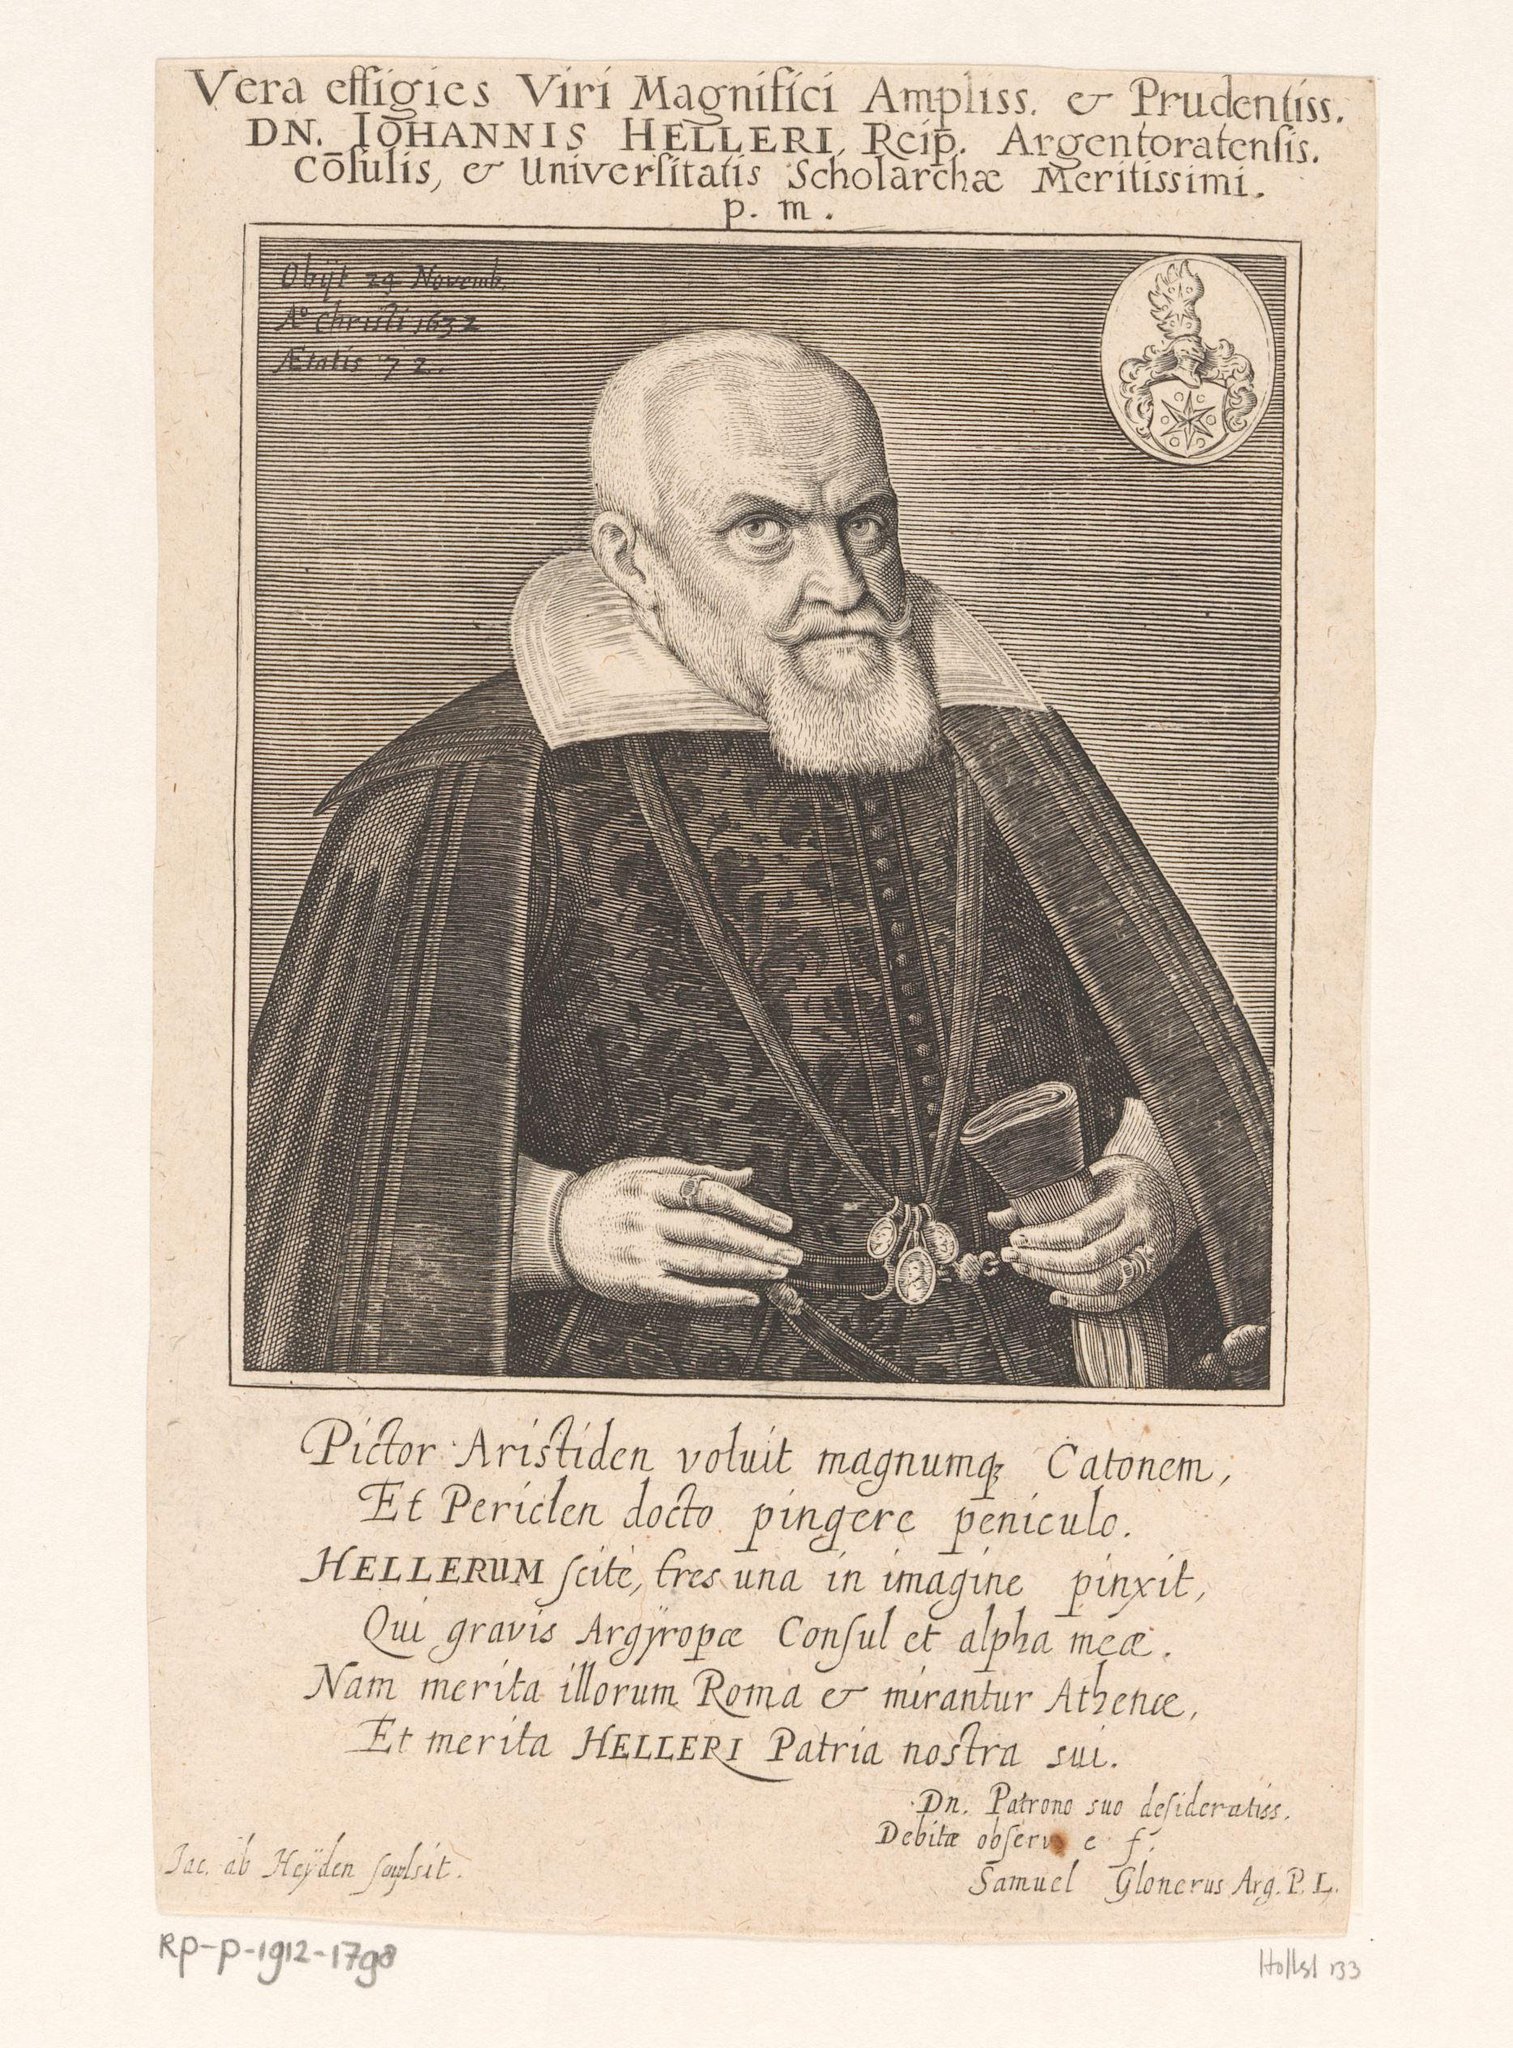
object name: print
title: Portret van Johann Heller op 72-jarige leeftijd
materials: paper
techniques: engraving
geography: straatsburg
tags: mayor, gloves, mittens, etc., historical persons, pendant, trinket, 'breloque', armorial bearing, heraldry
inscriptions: collector's mark: Lugt 2228